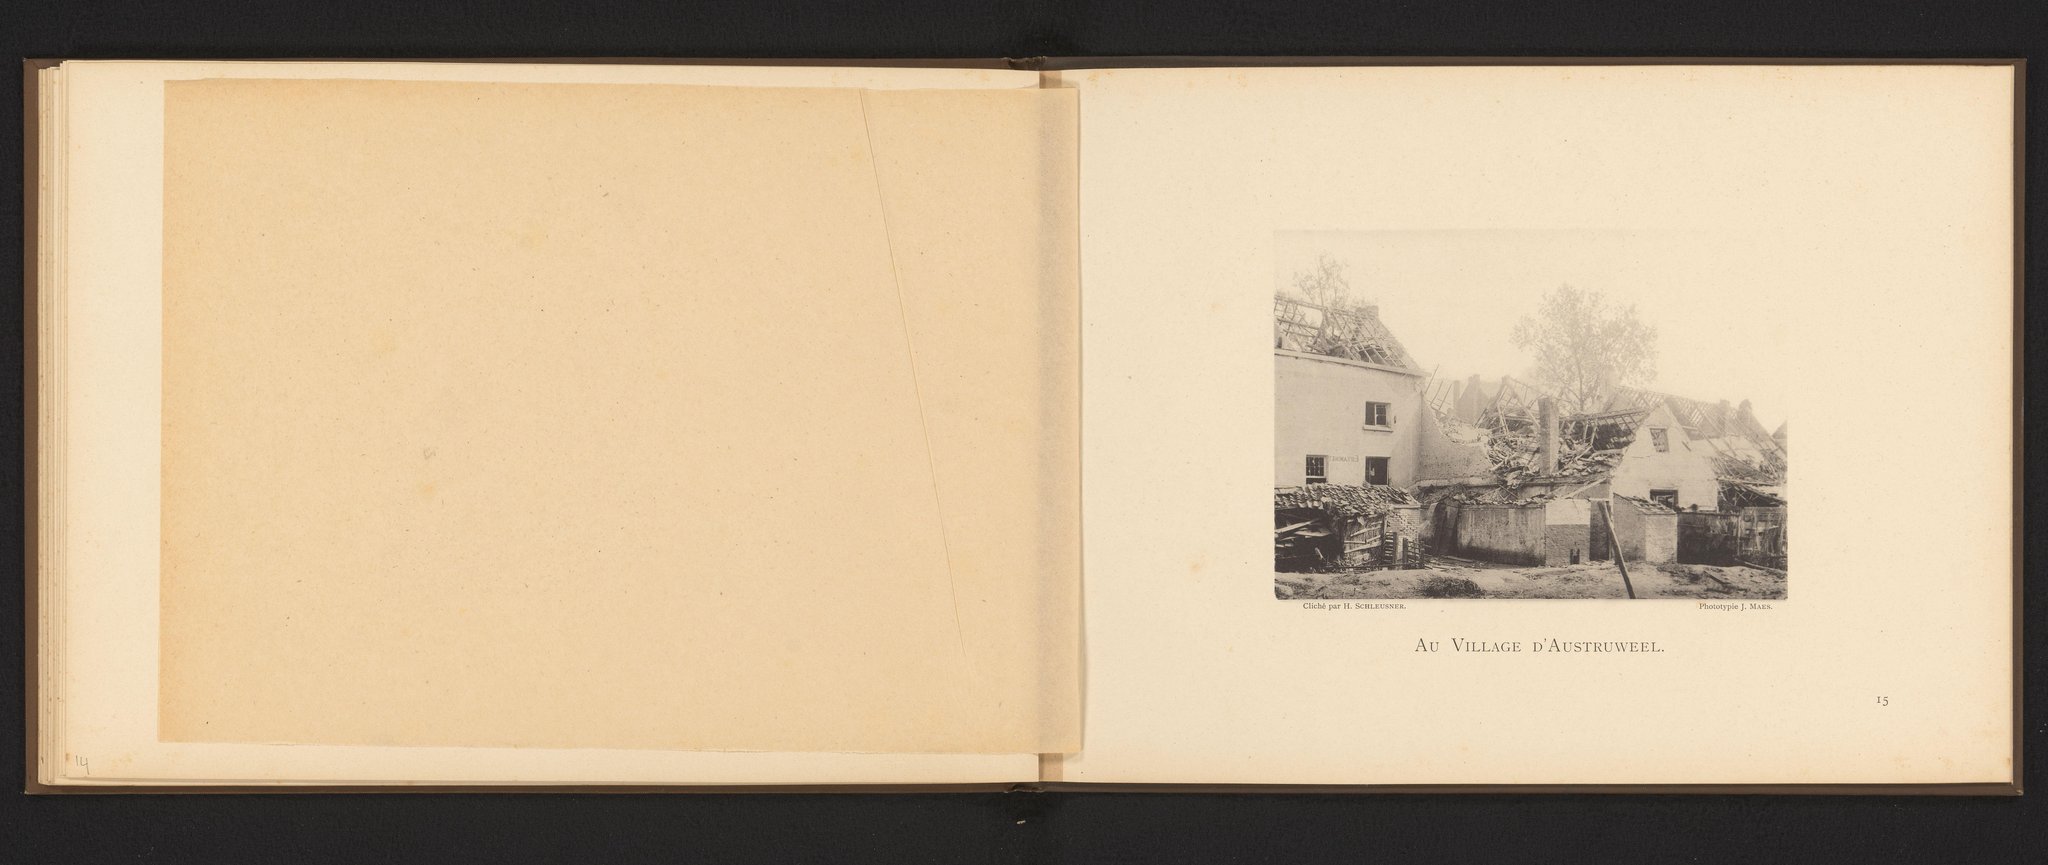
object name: photomechanical print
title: Au village d'Austruweel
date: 1889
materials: paper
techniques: photograph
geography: oosterweel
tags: ruin of a building ~ architecture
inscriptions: number: ‘15’